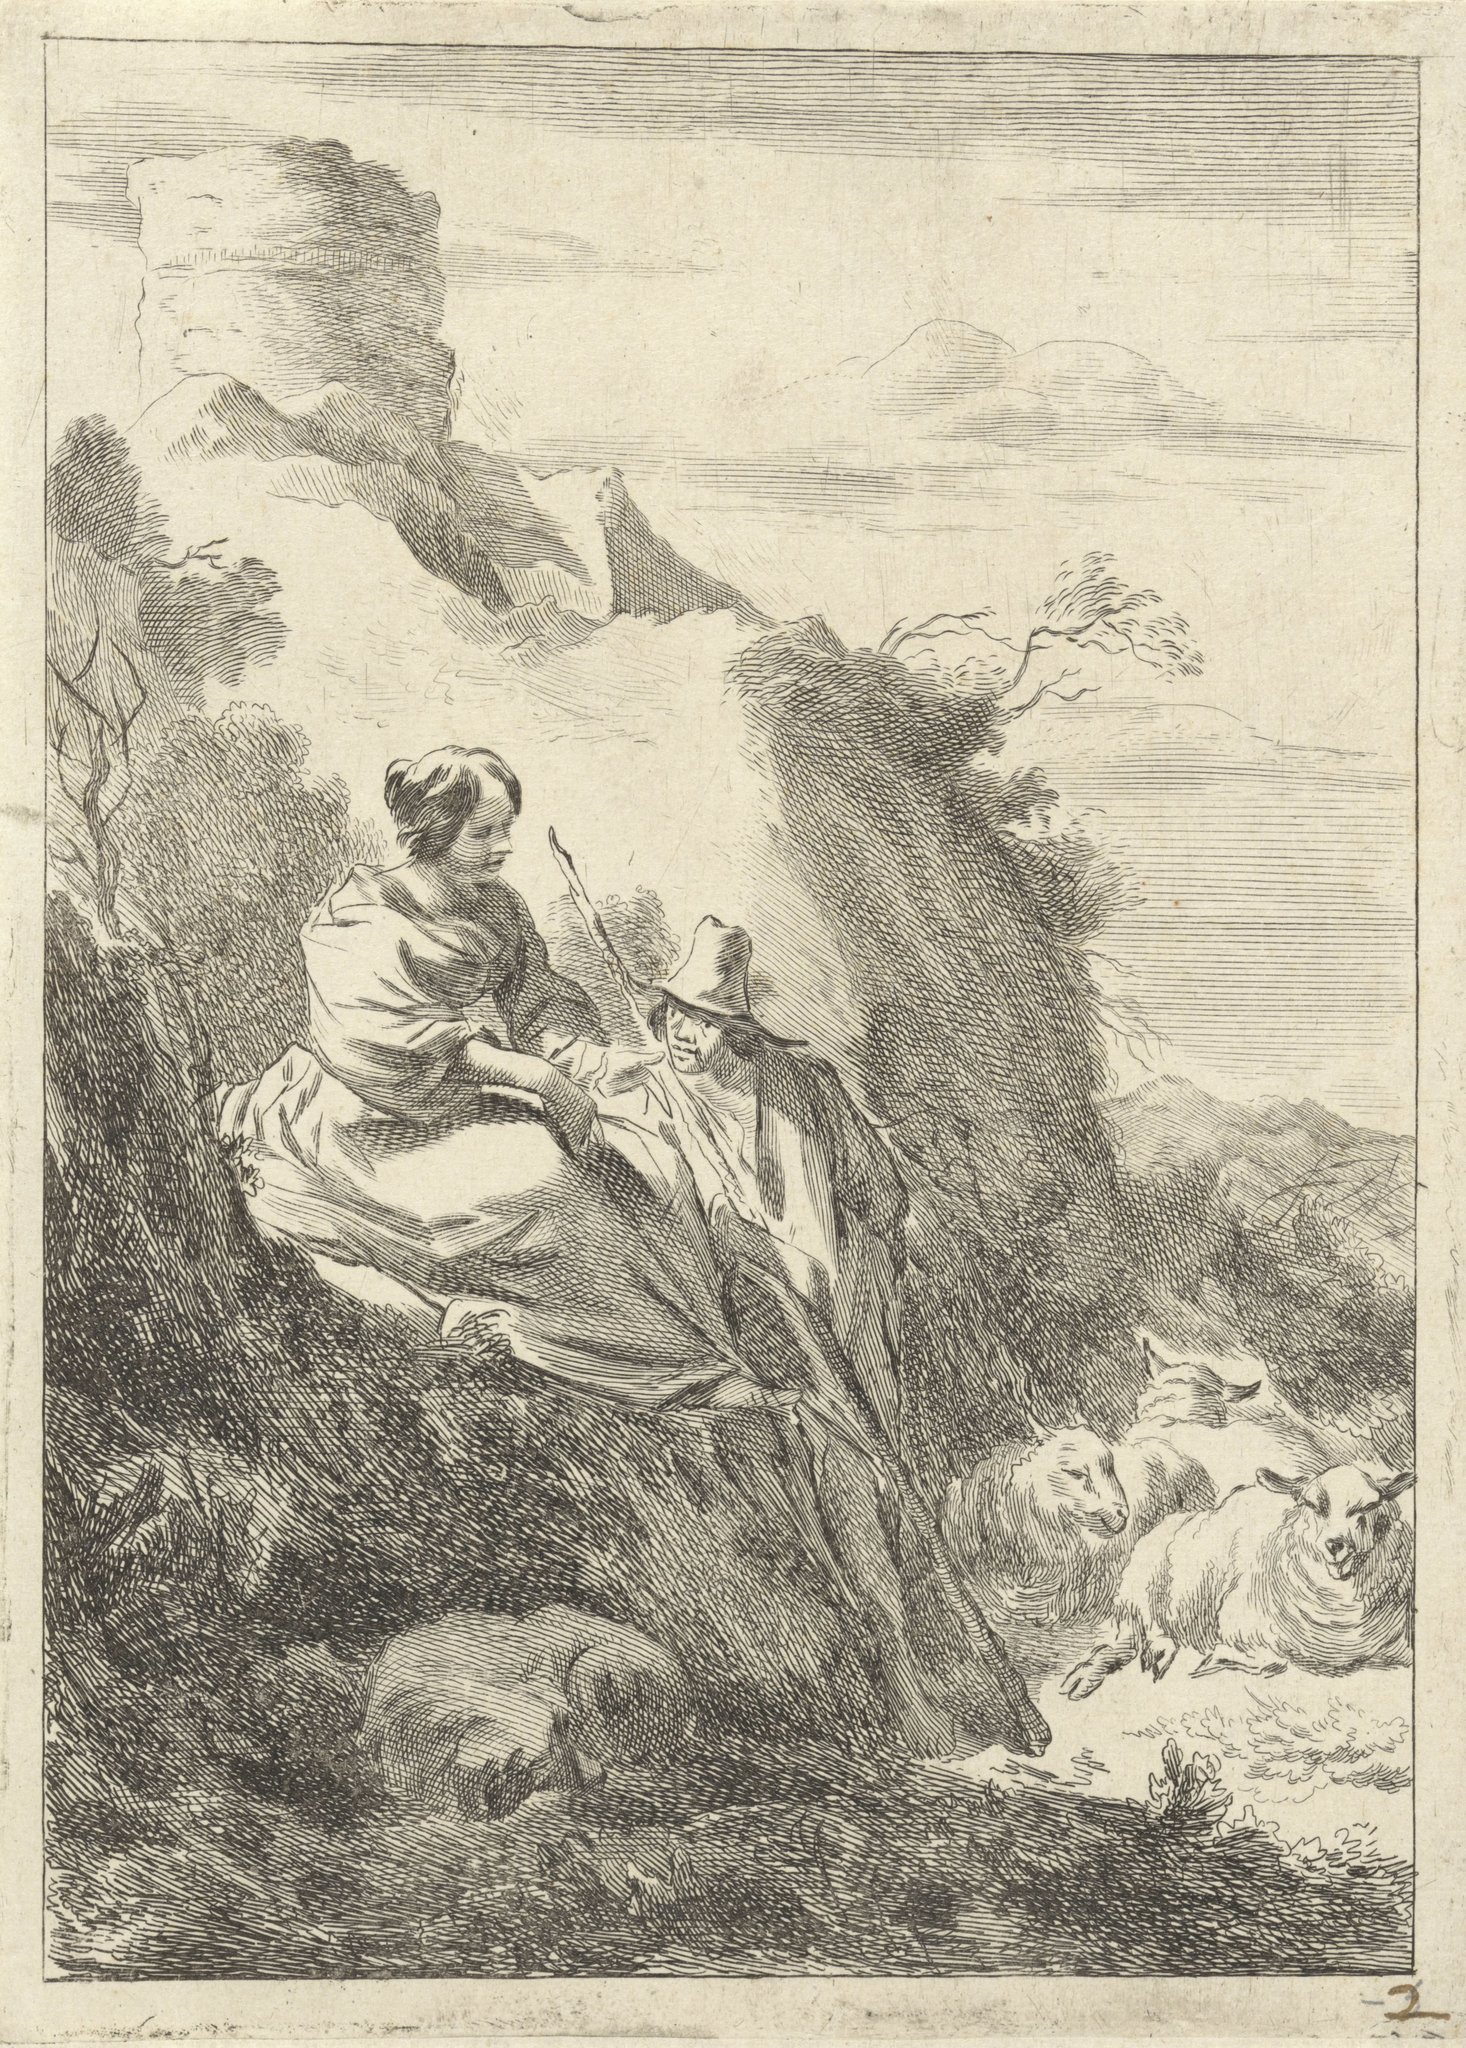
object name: print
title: Op een heuvel zit een herderin en staat een herder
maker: jan de visscher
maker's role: print maker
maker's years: 1633-1712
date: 1643-1692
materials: paper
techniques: engraving, etching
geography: northern netherlands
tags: herding, herdsman, herdswoman, shepherd, shepherdess, cowherd, etc., sheep, landscape with tower or castle - ii - ideal landscapes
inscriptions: collector's mark: Lugt 2228